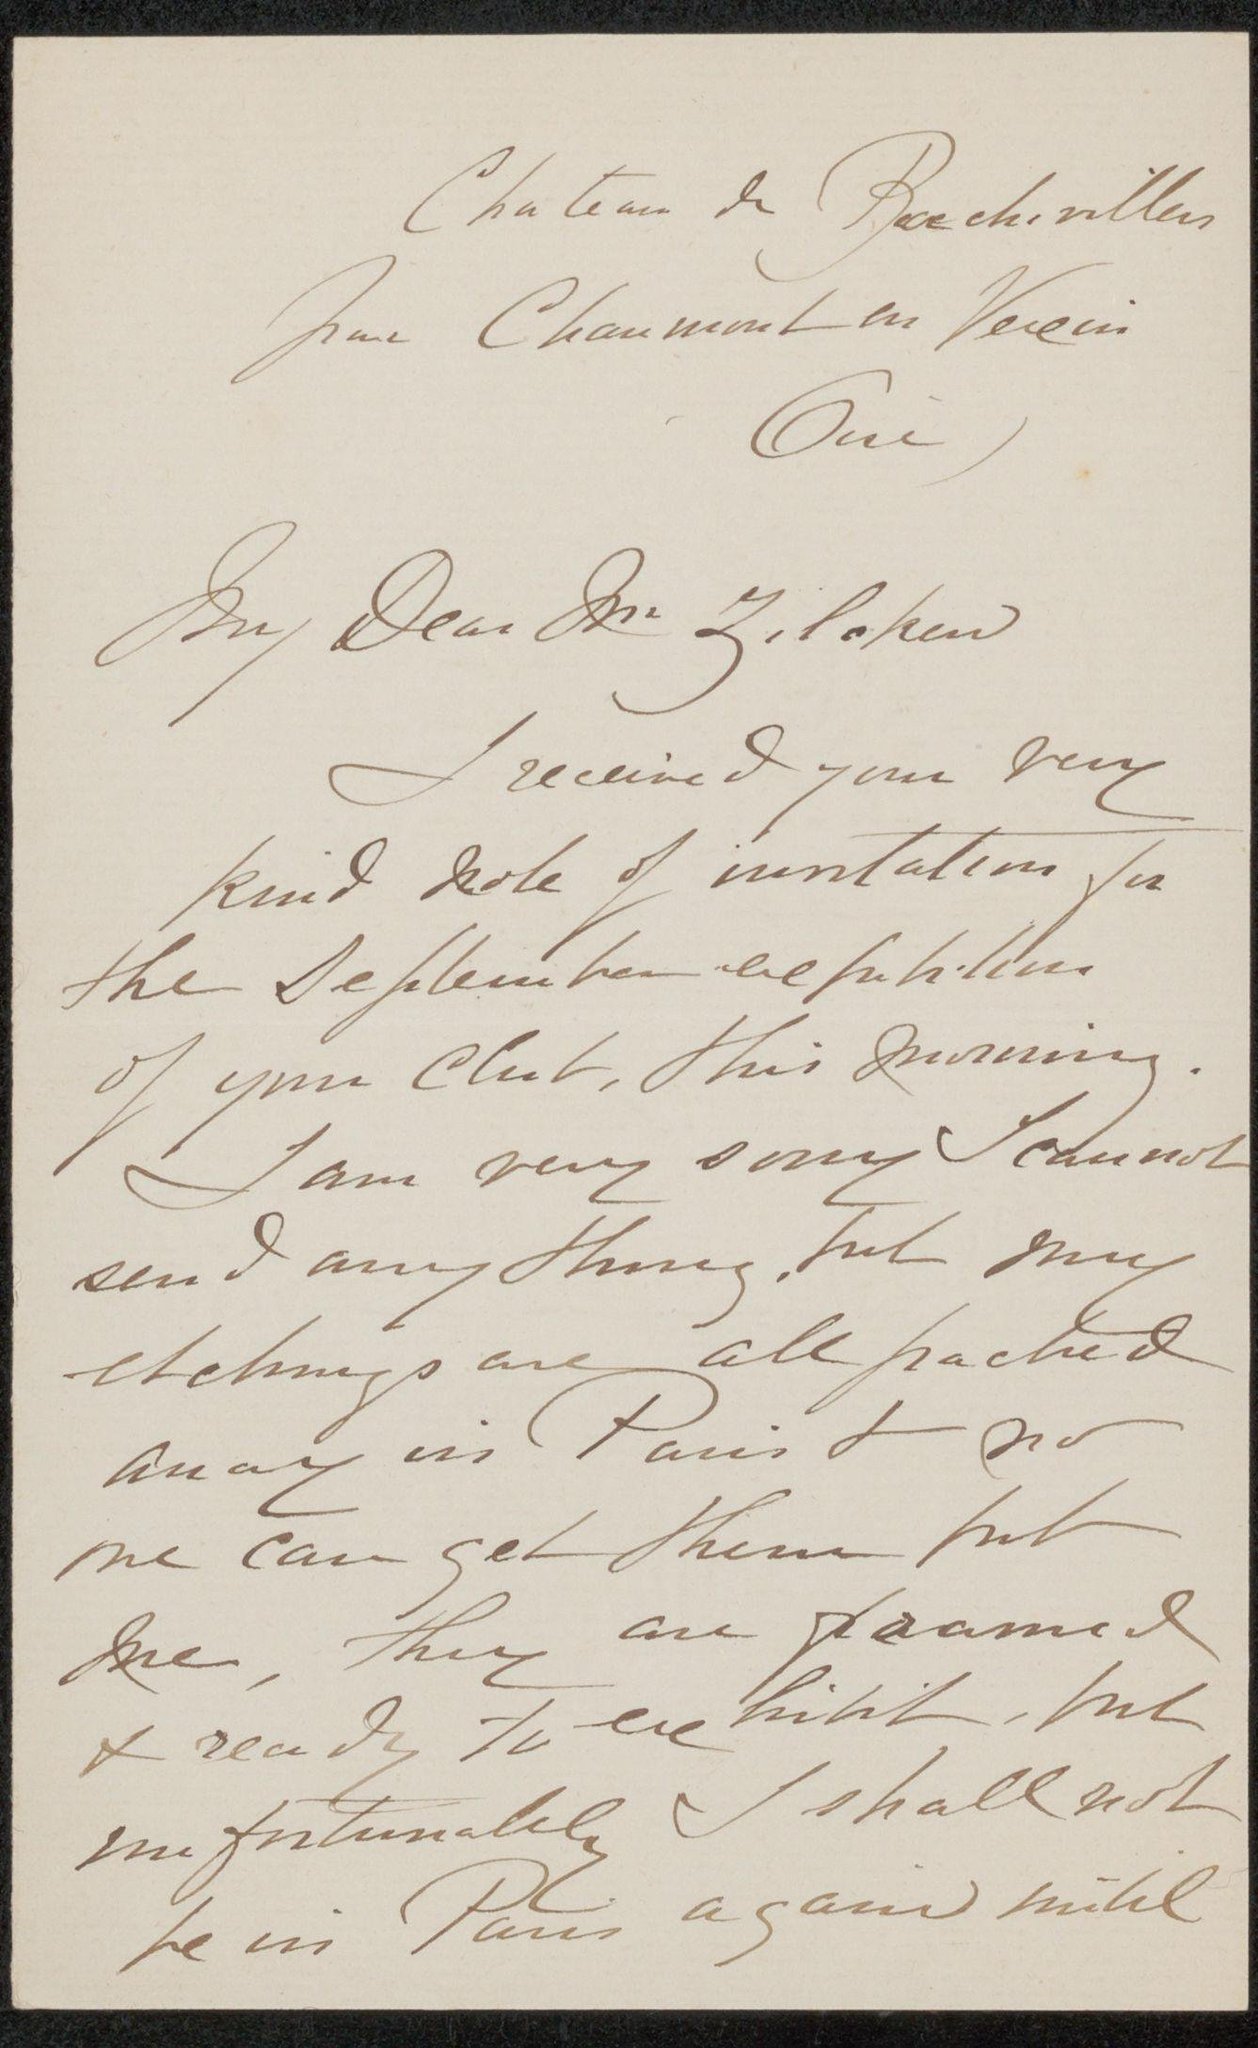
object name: letter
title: Brief aan Philip Zilcken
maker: mary cassatt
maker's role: print maker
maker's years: 1844-1926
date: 1854-1926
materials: ink, paper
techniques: pen, writing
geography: château de bachivillers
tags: painter, draughtsman, philip zilcken, paris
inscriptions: watermark, collector's mark: ‘RPK’